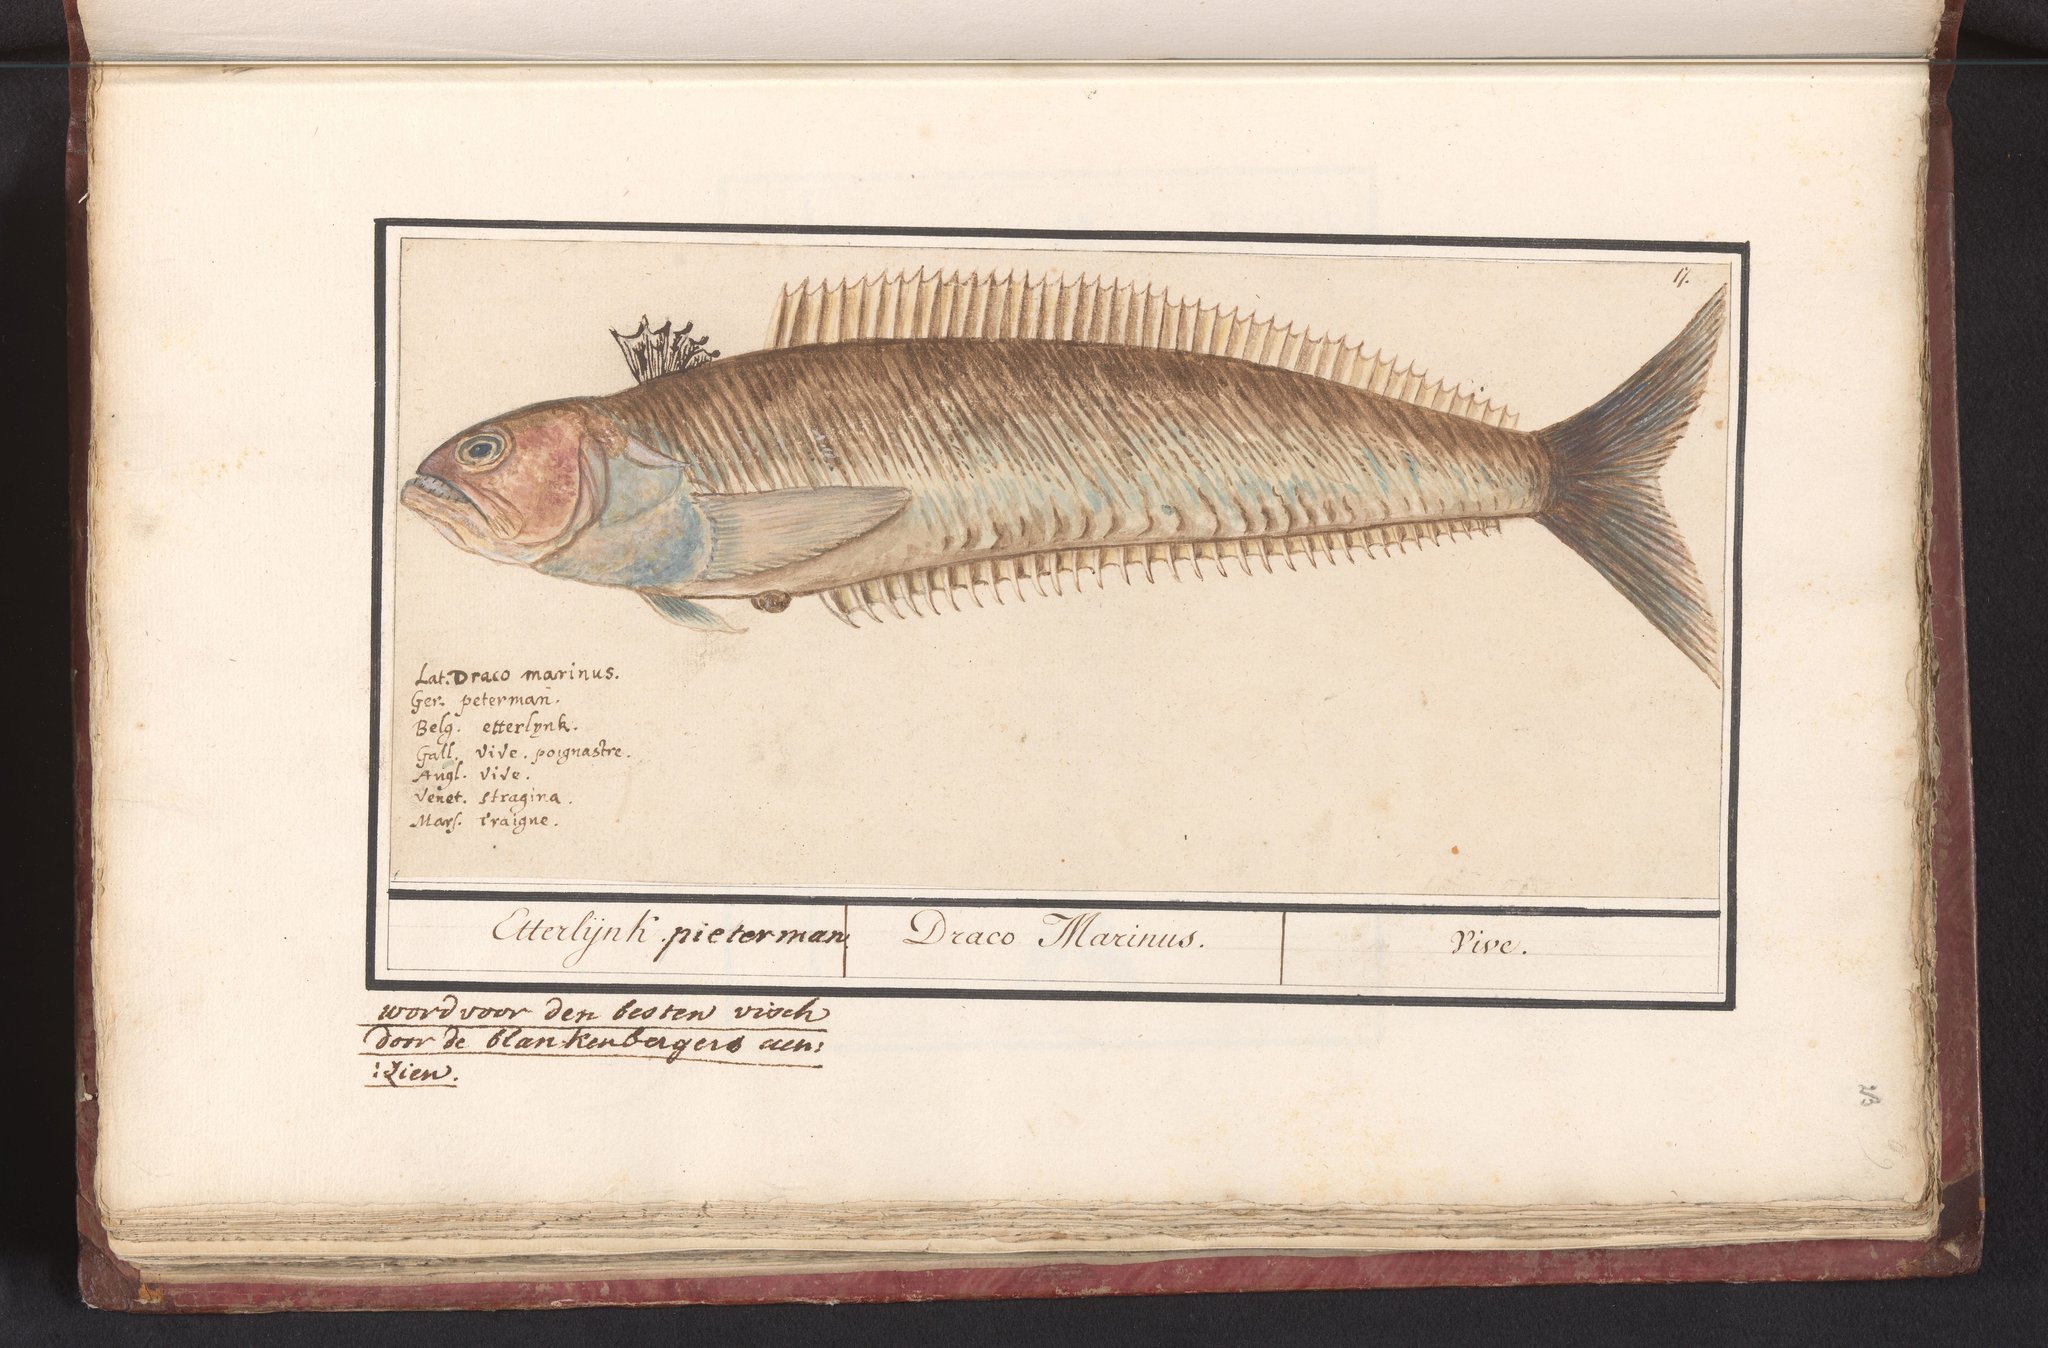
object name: drawing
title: Etterlijnk. pieterman / Draco Marinus. / Vive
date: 1596-1610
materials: chalk, paint, ink, paper, pencil, watercolor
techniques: brush, pen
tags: bony fishes: weever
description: Een baarsachtige, mogelijk een pieterman. De gelijkenis met een pieterman veroorzaakt door de latere toevoeging van de eerste rugvin met doornige vinstralen. Genummerd rechtsboven: 17. Linksonder de naam in zeven talen. Onderdeel van het zesde album met tekeningen van vissen, schelpen en insekten. Zesde van twaalf albums met tekeningen van dieren, vogels en planten bekend rond 1600, gemaakt in opdracht van keizer Rudolf II. Met toelichting in Nederlands, Latijn en Frans.